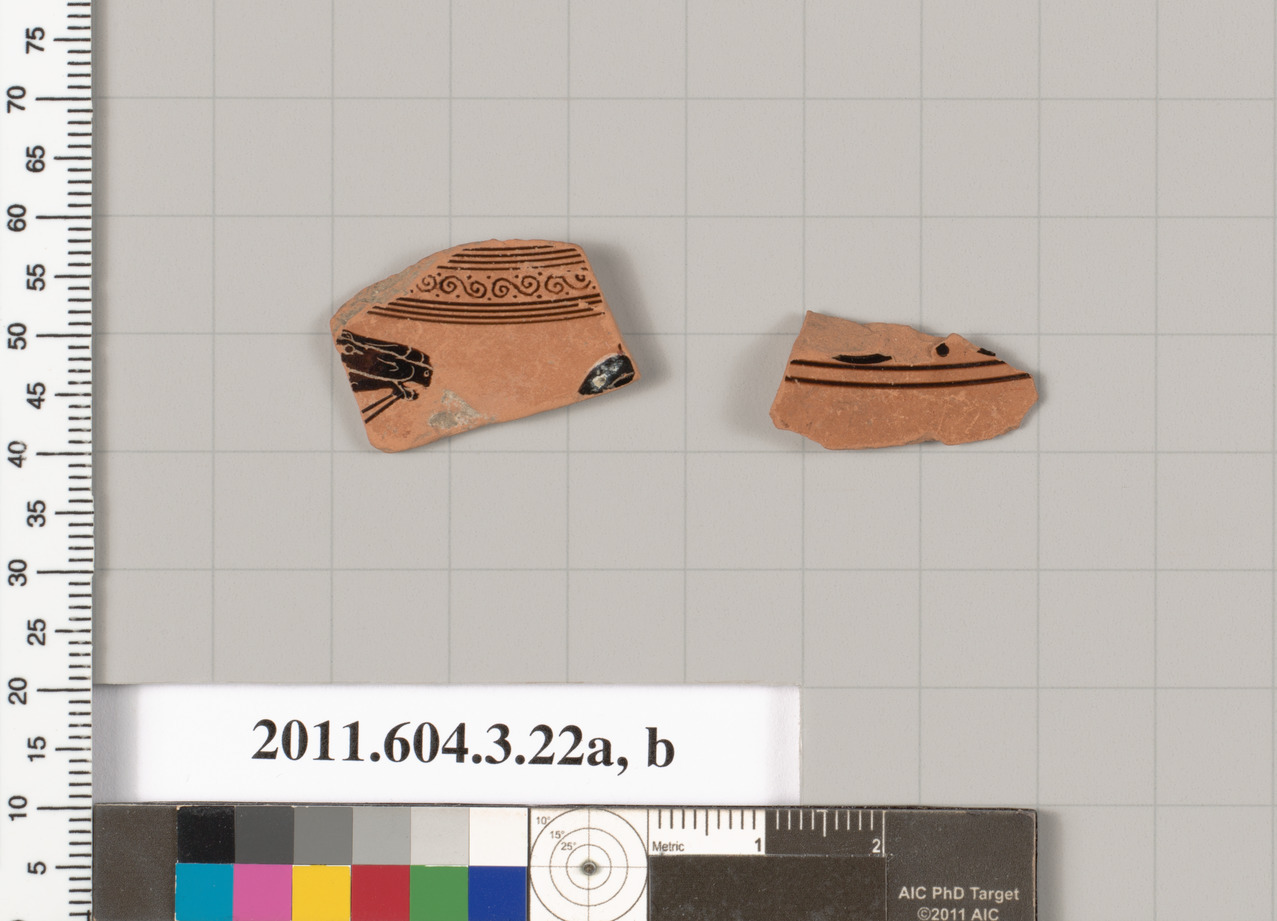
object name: pyxis fragment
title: Terracotta fragments of a pyxis (box)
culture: greek, attic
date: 550-526 BCE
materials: terracotta